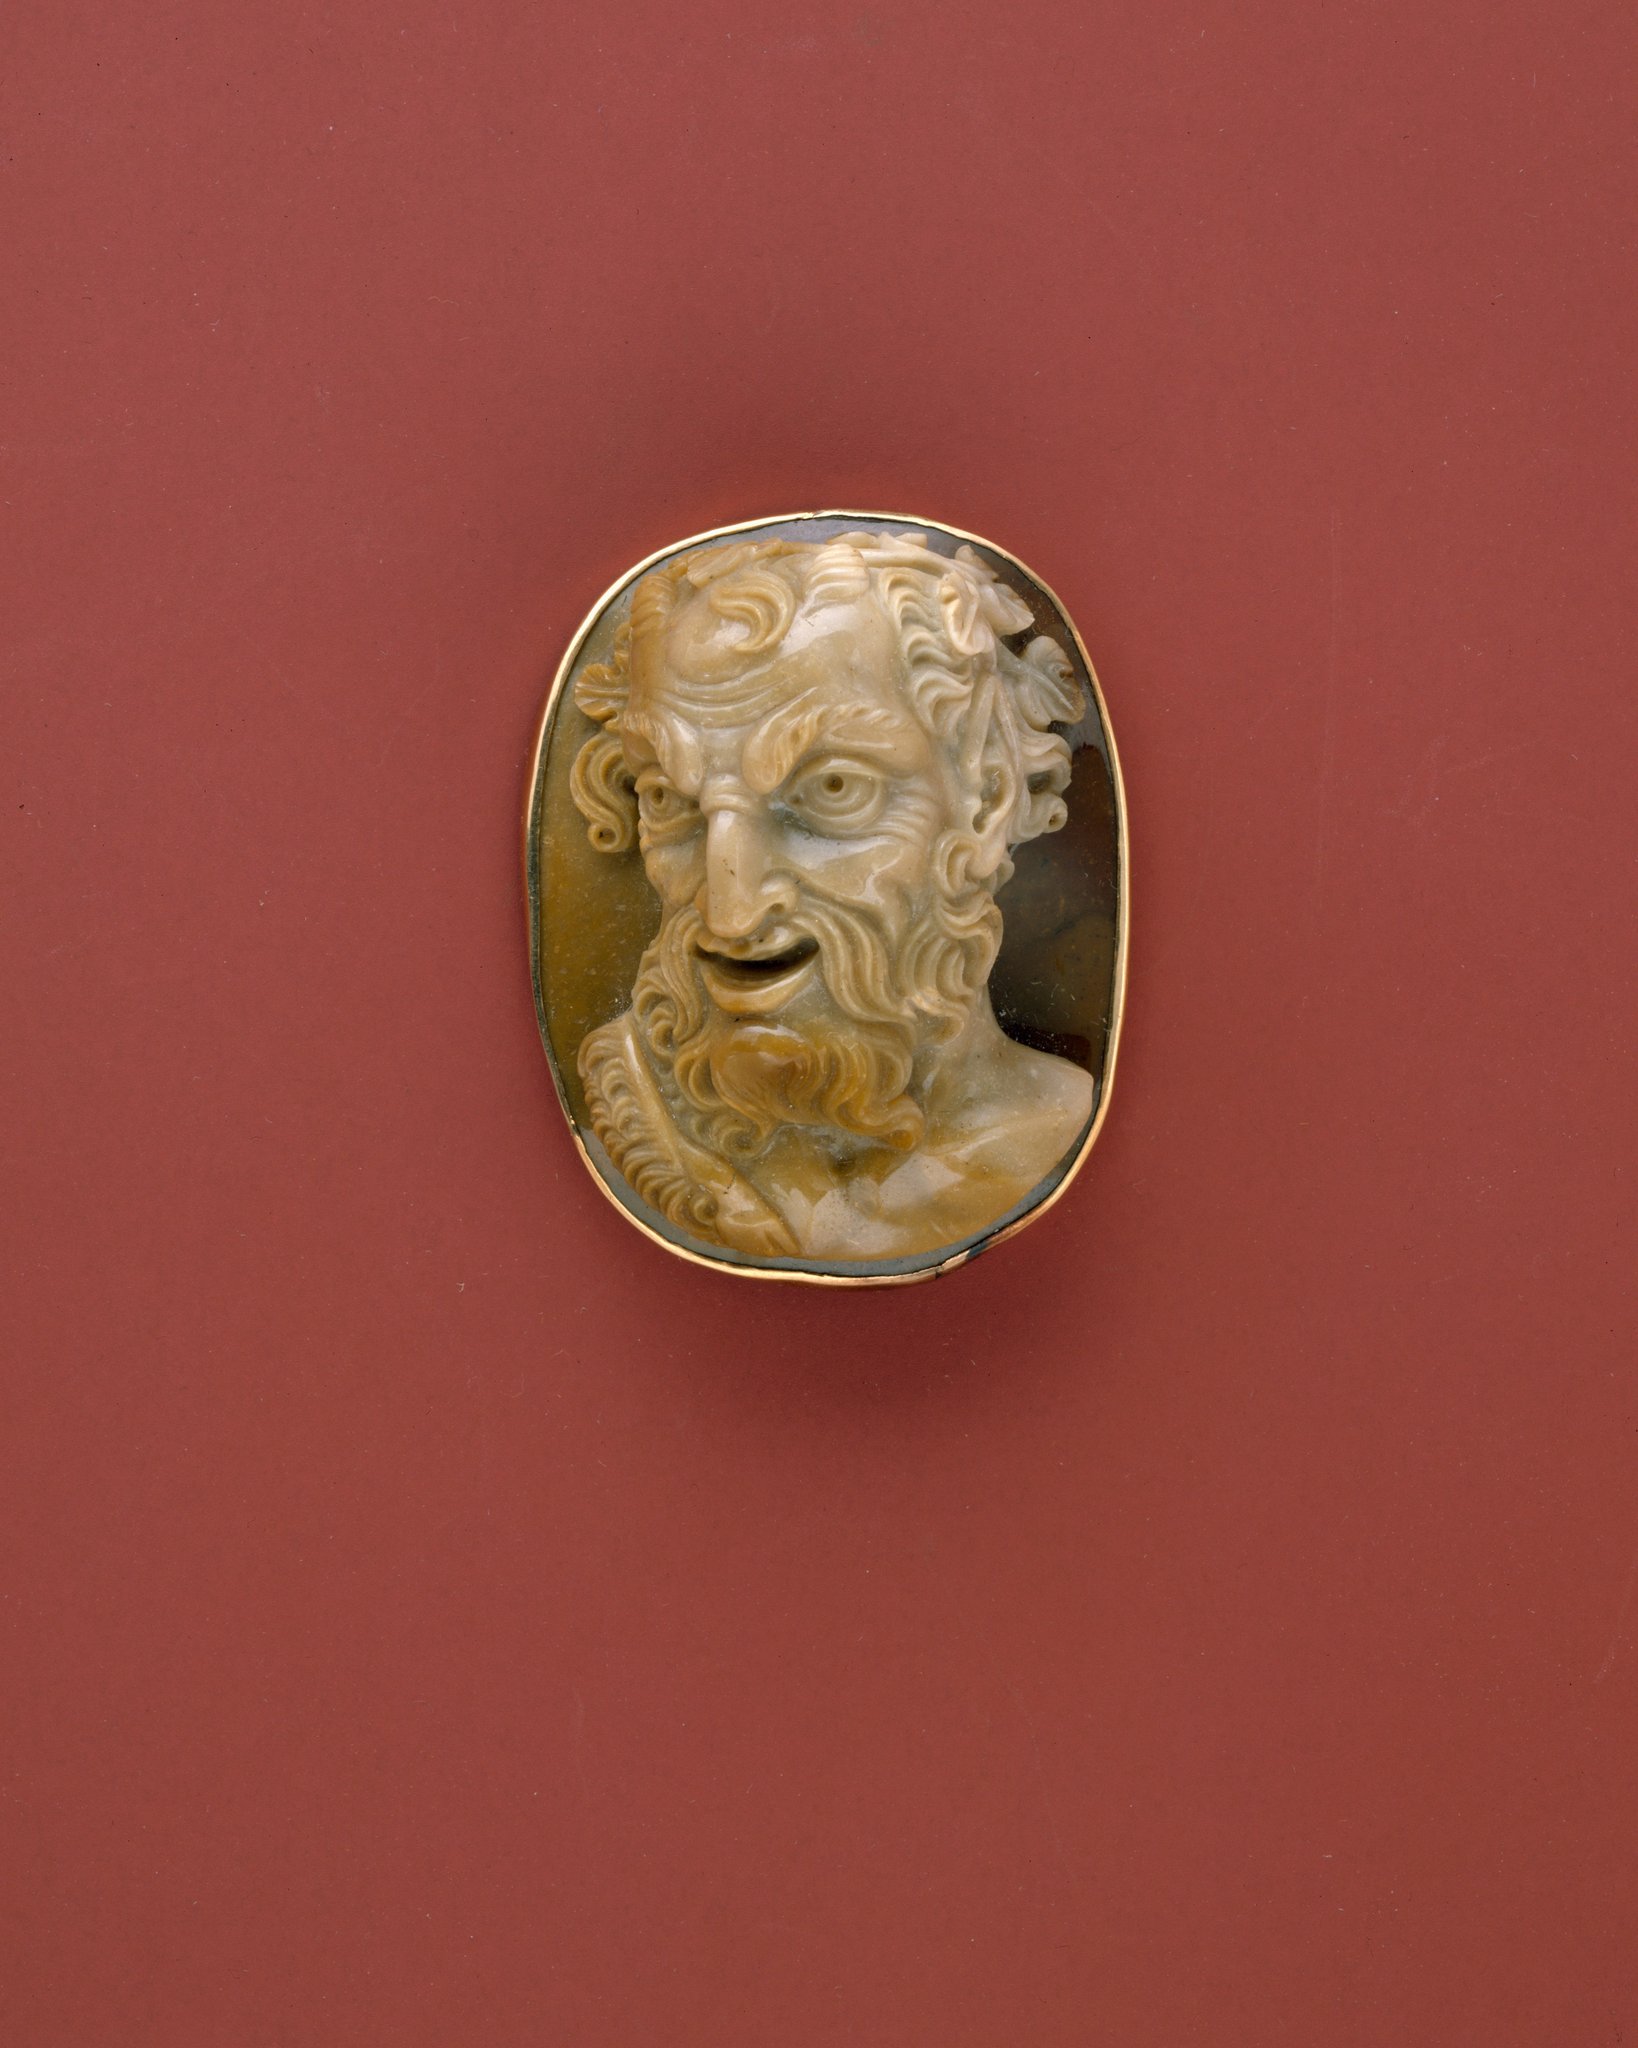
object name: cameo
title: Cameo with the Head of a Satyr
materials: gold, gemstone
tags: men,satyrs